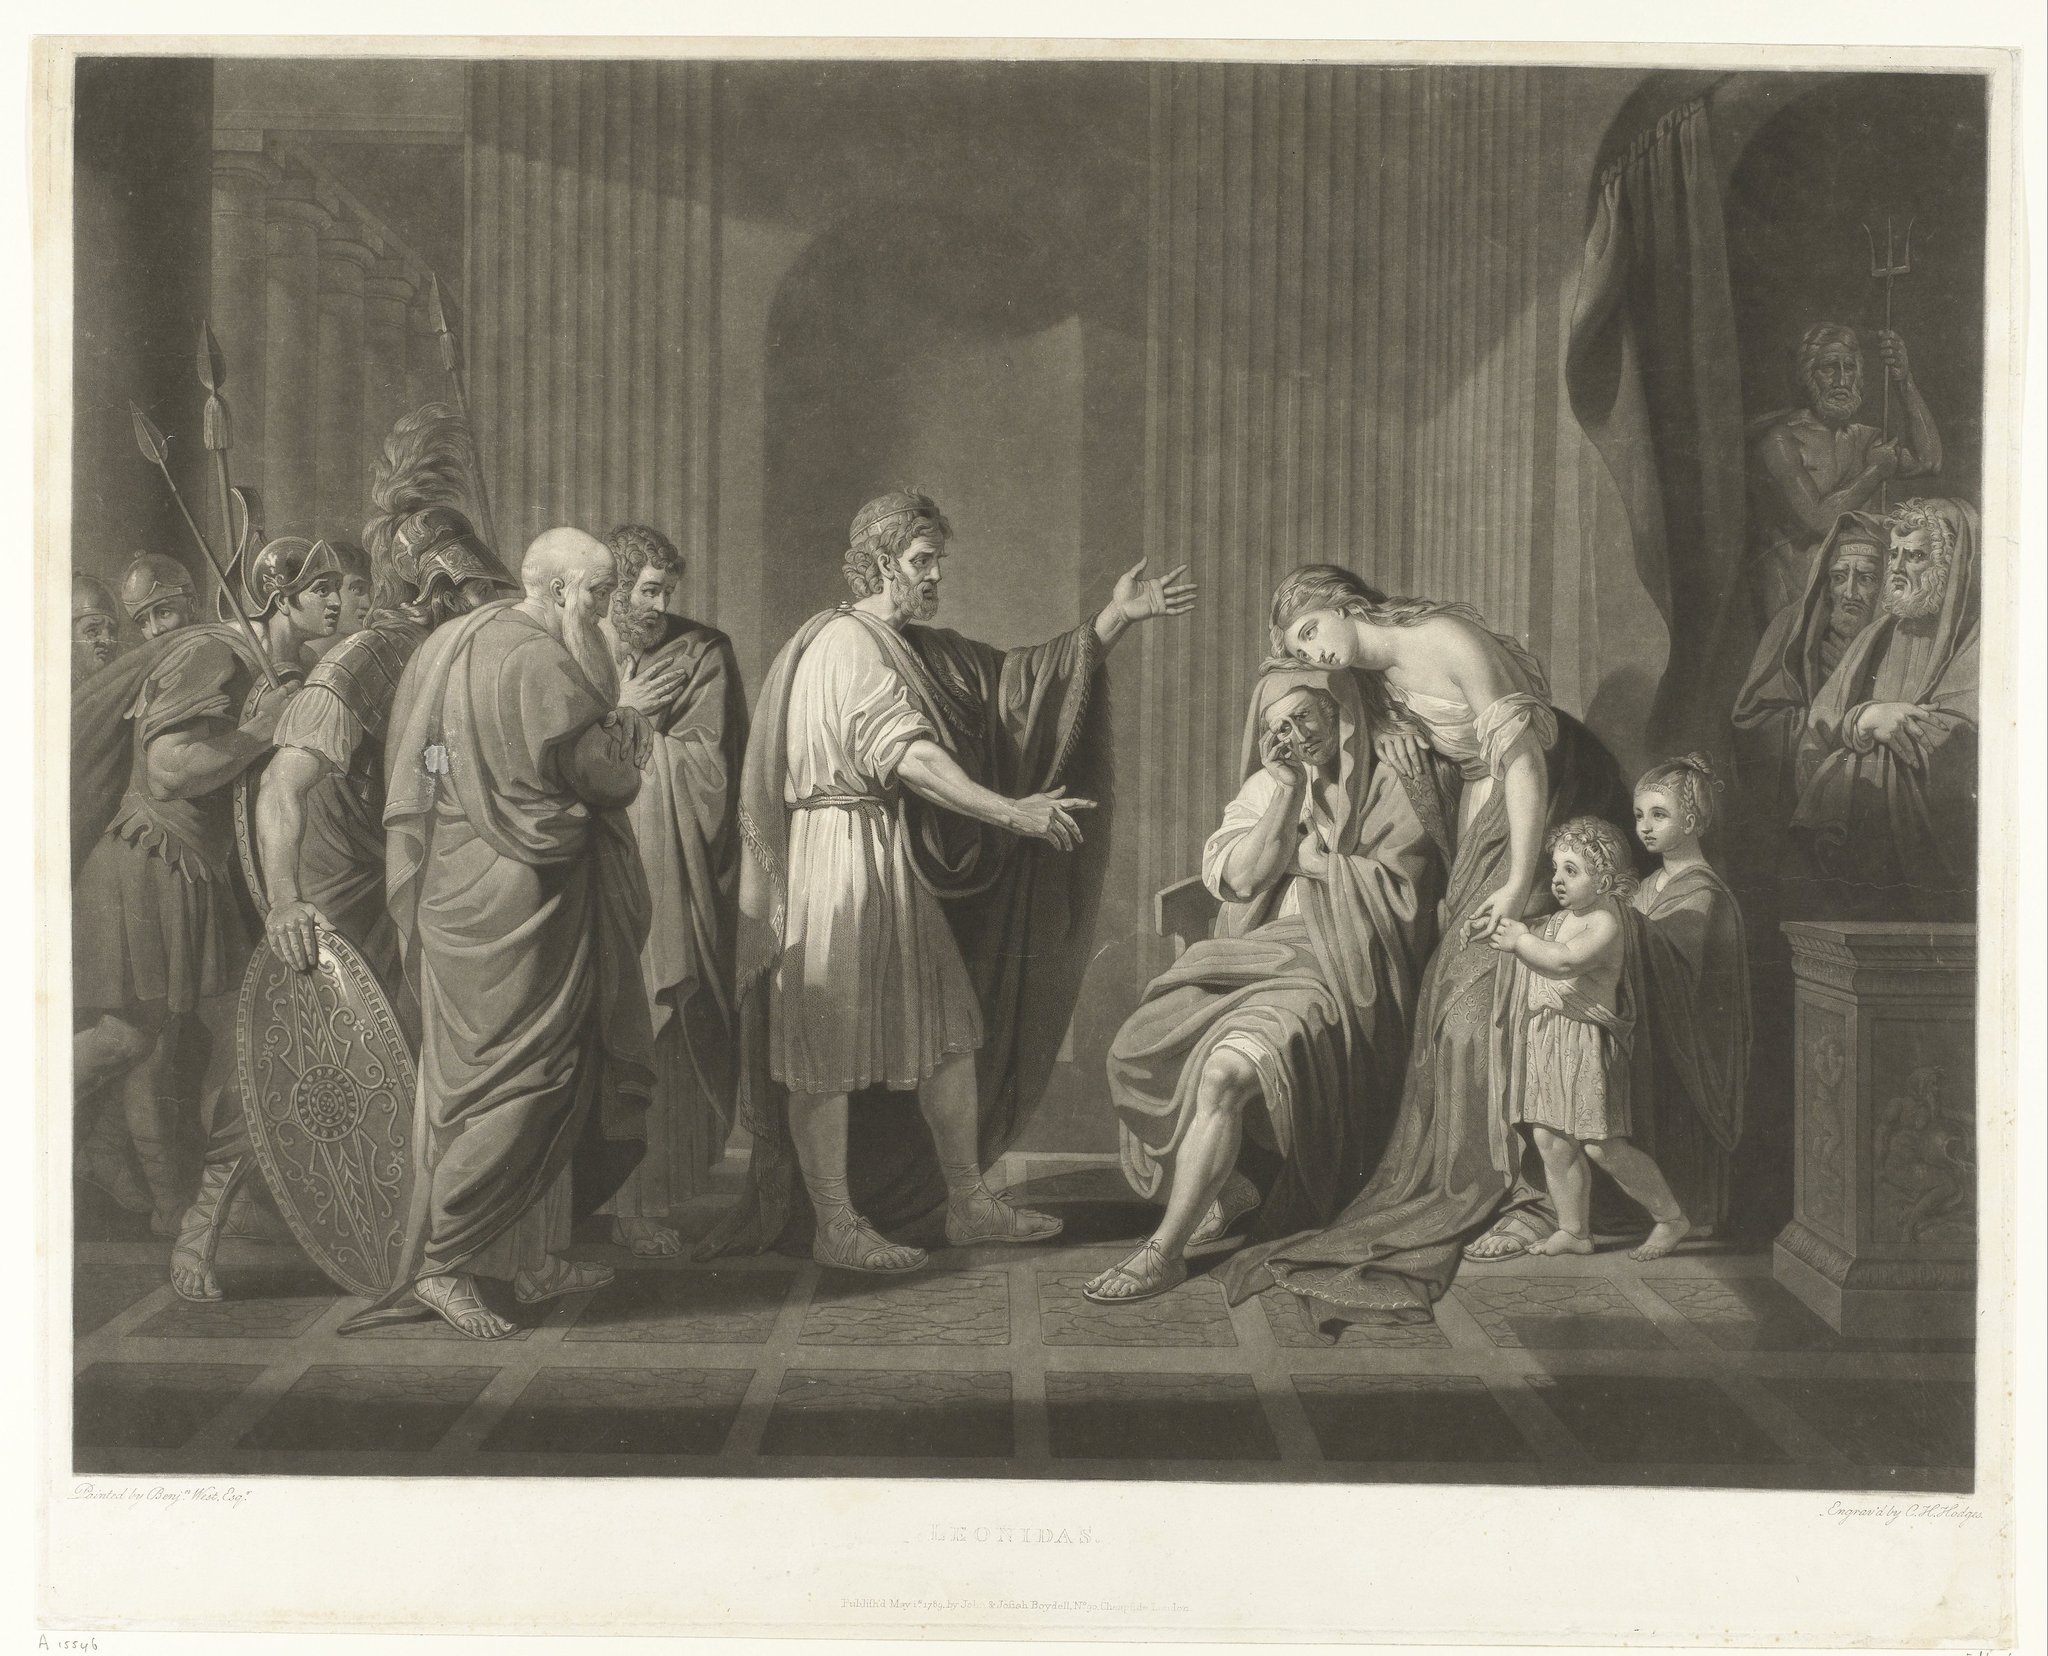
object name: print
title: Leonidas.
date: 1789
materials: paper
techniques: mezzotint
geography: london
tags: banishment, exile, (story of) leonidas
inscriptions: collector's mark: Lugt 2228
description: Koning Leonidas II spreekt de verbanning van Cleombrotus II uit, die in gedachten verzonken luistert. Zijn vrouw Cheilonis, tevens de dochter van Leonidas II, smeekte haar vader eerder om Cleombrotus II niet te vermoorden en hen te sparen. Een groep soldaten kijkt toe.